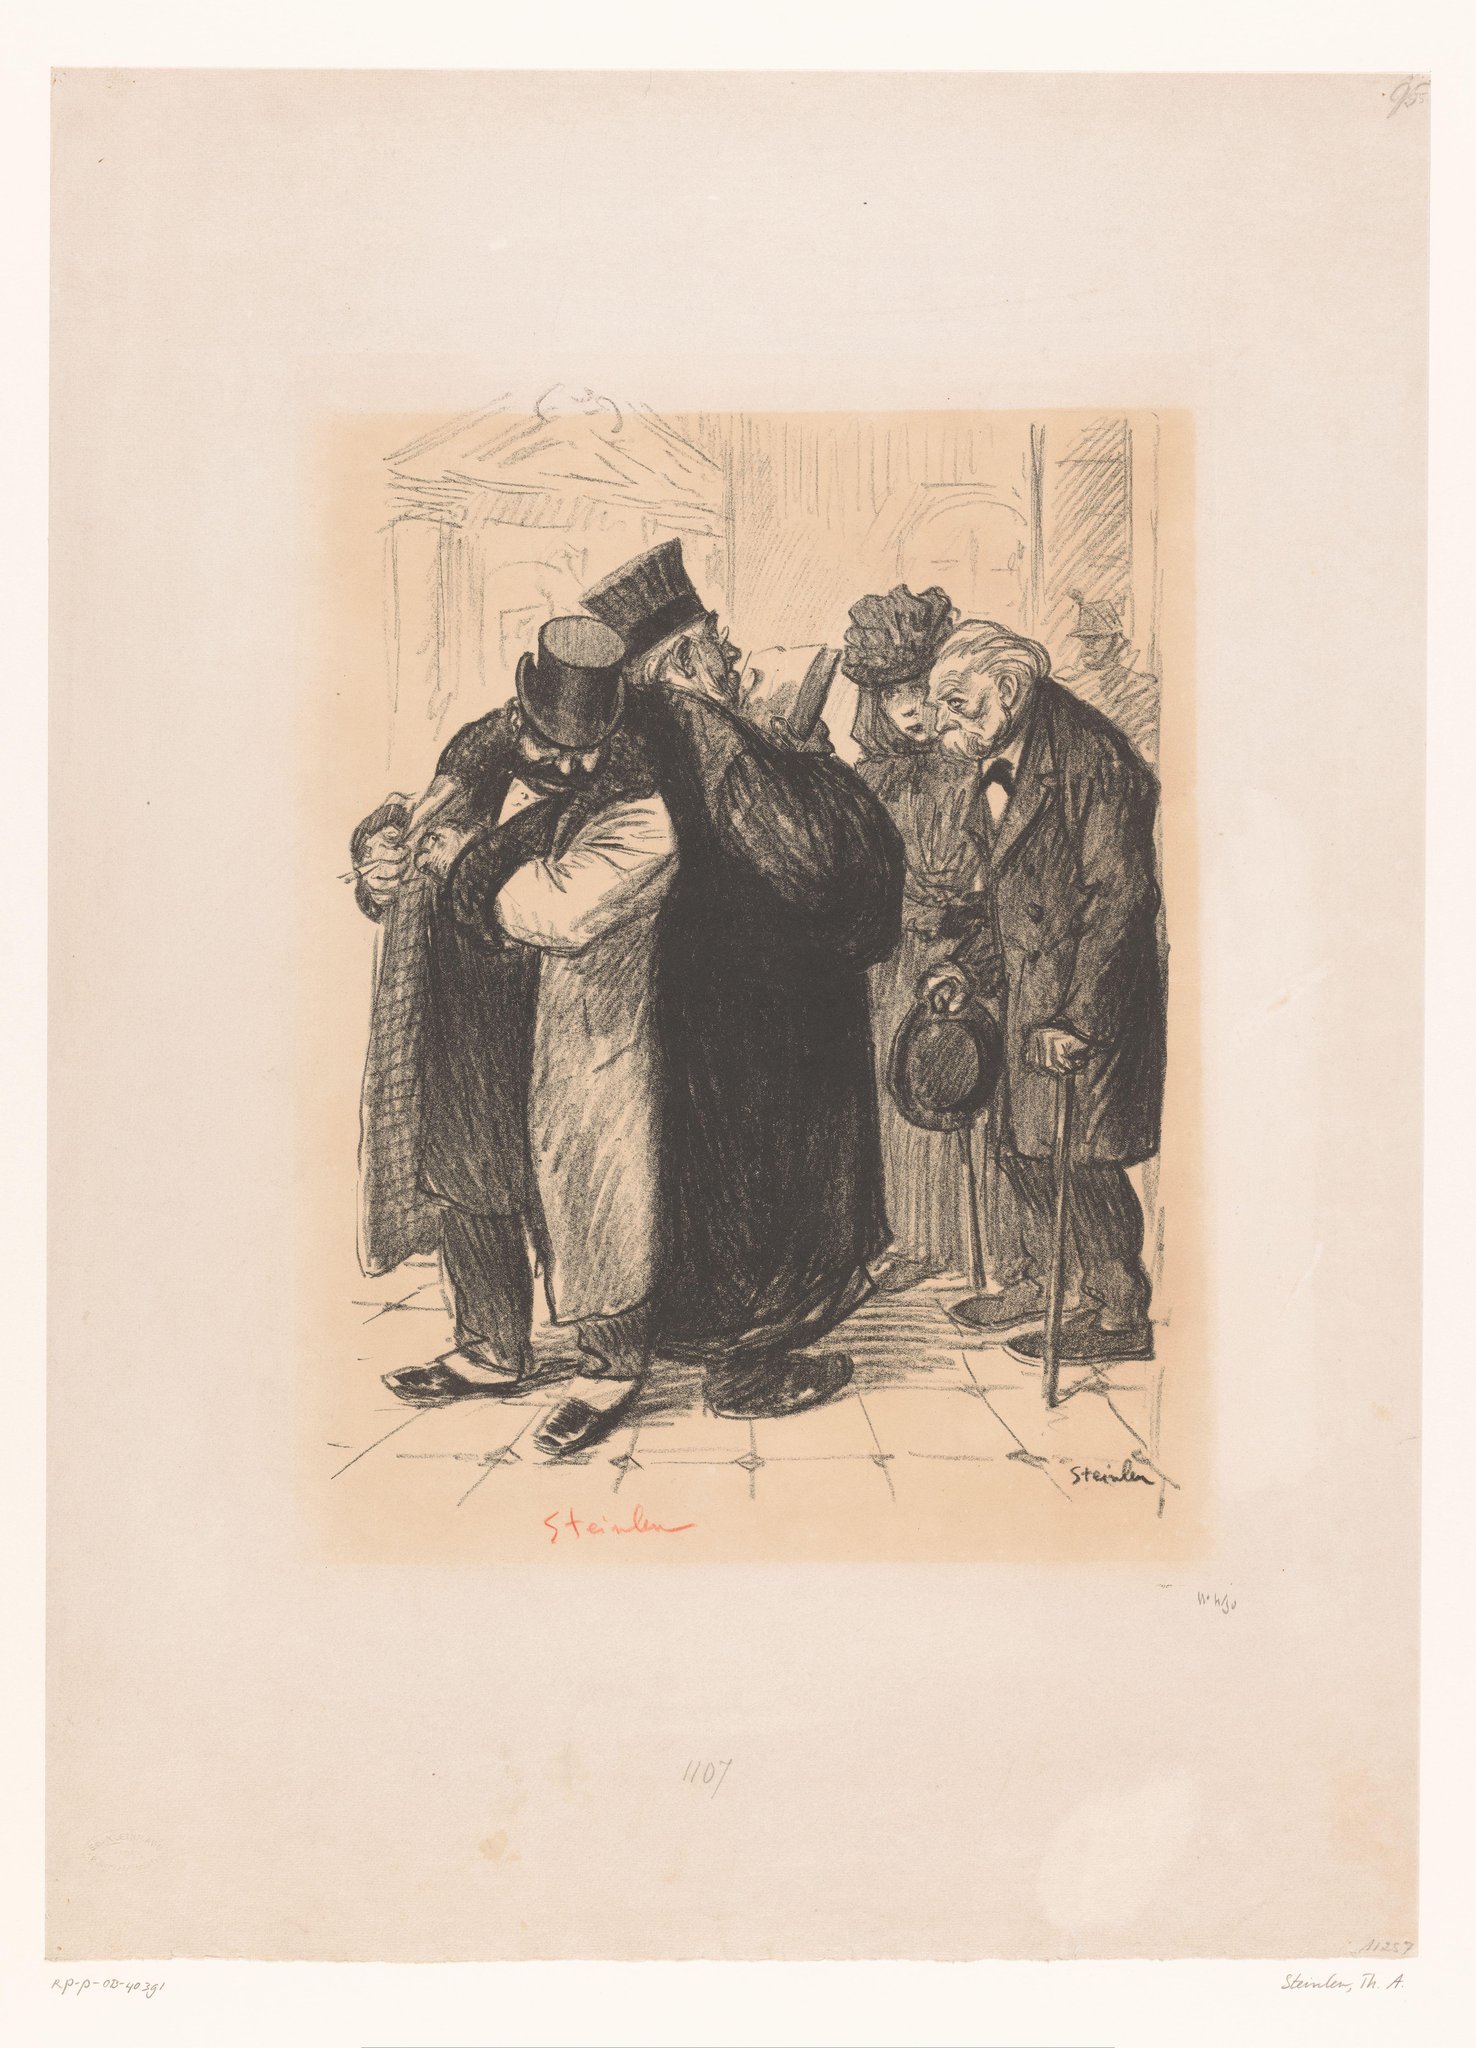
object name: print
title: Een advocaat met twee mannen en een vrouw in het paleis van justitie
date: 1898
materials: paper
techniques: tone lithography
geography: paris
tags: court building, lawyer, attorney at law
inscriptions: check stamp: Lugt 1573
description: Reproductie verschenen in: La Feuille, vol. 22, 21 december 1898.